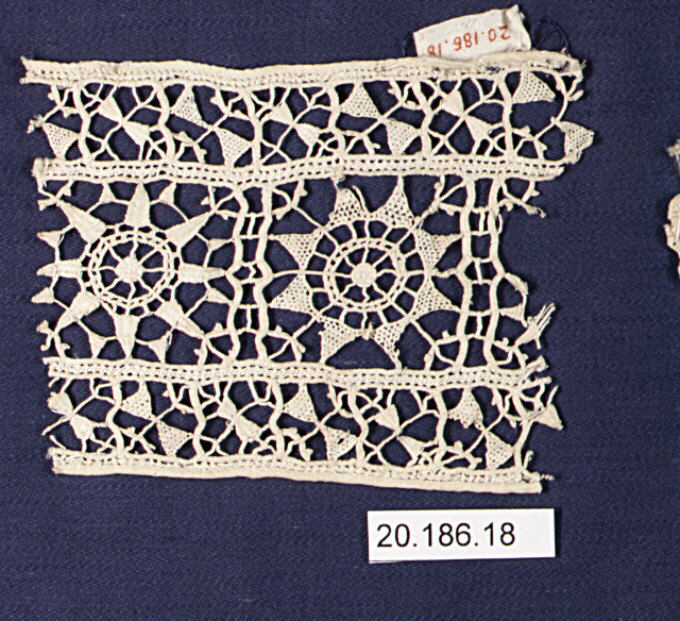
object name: fragment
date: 1501-1600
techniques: lace